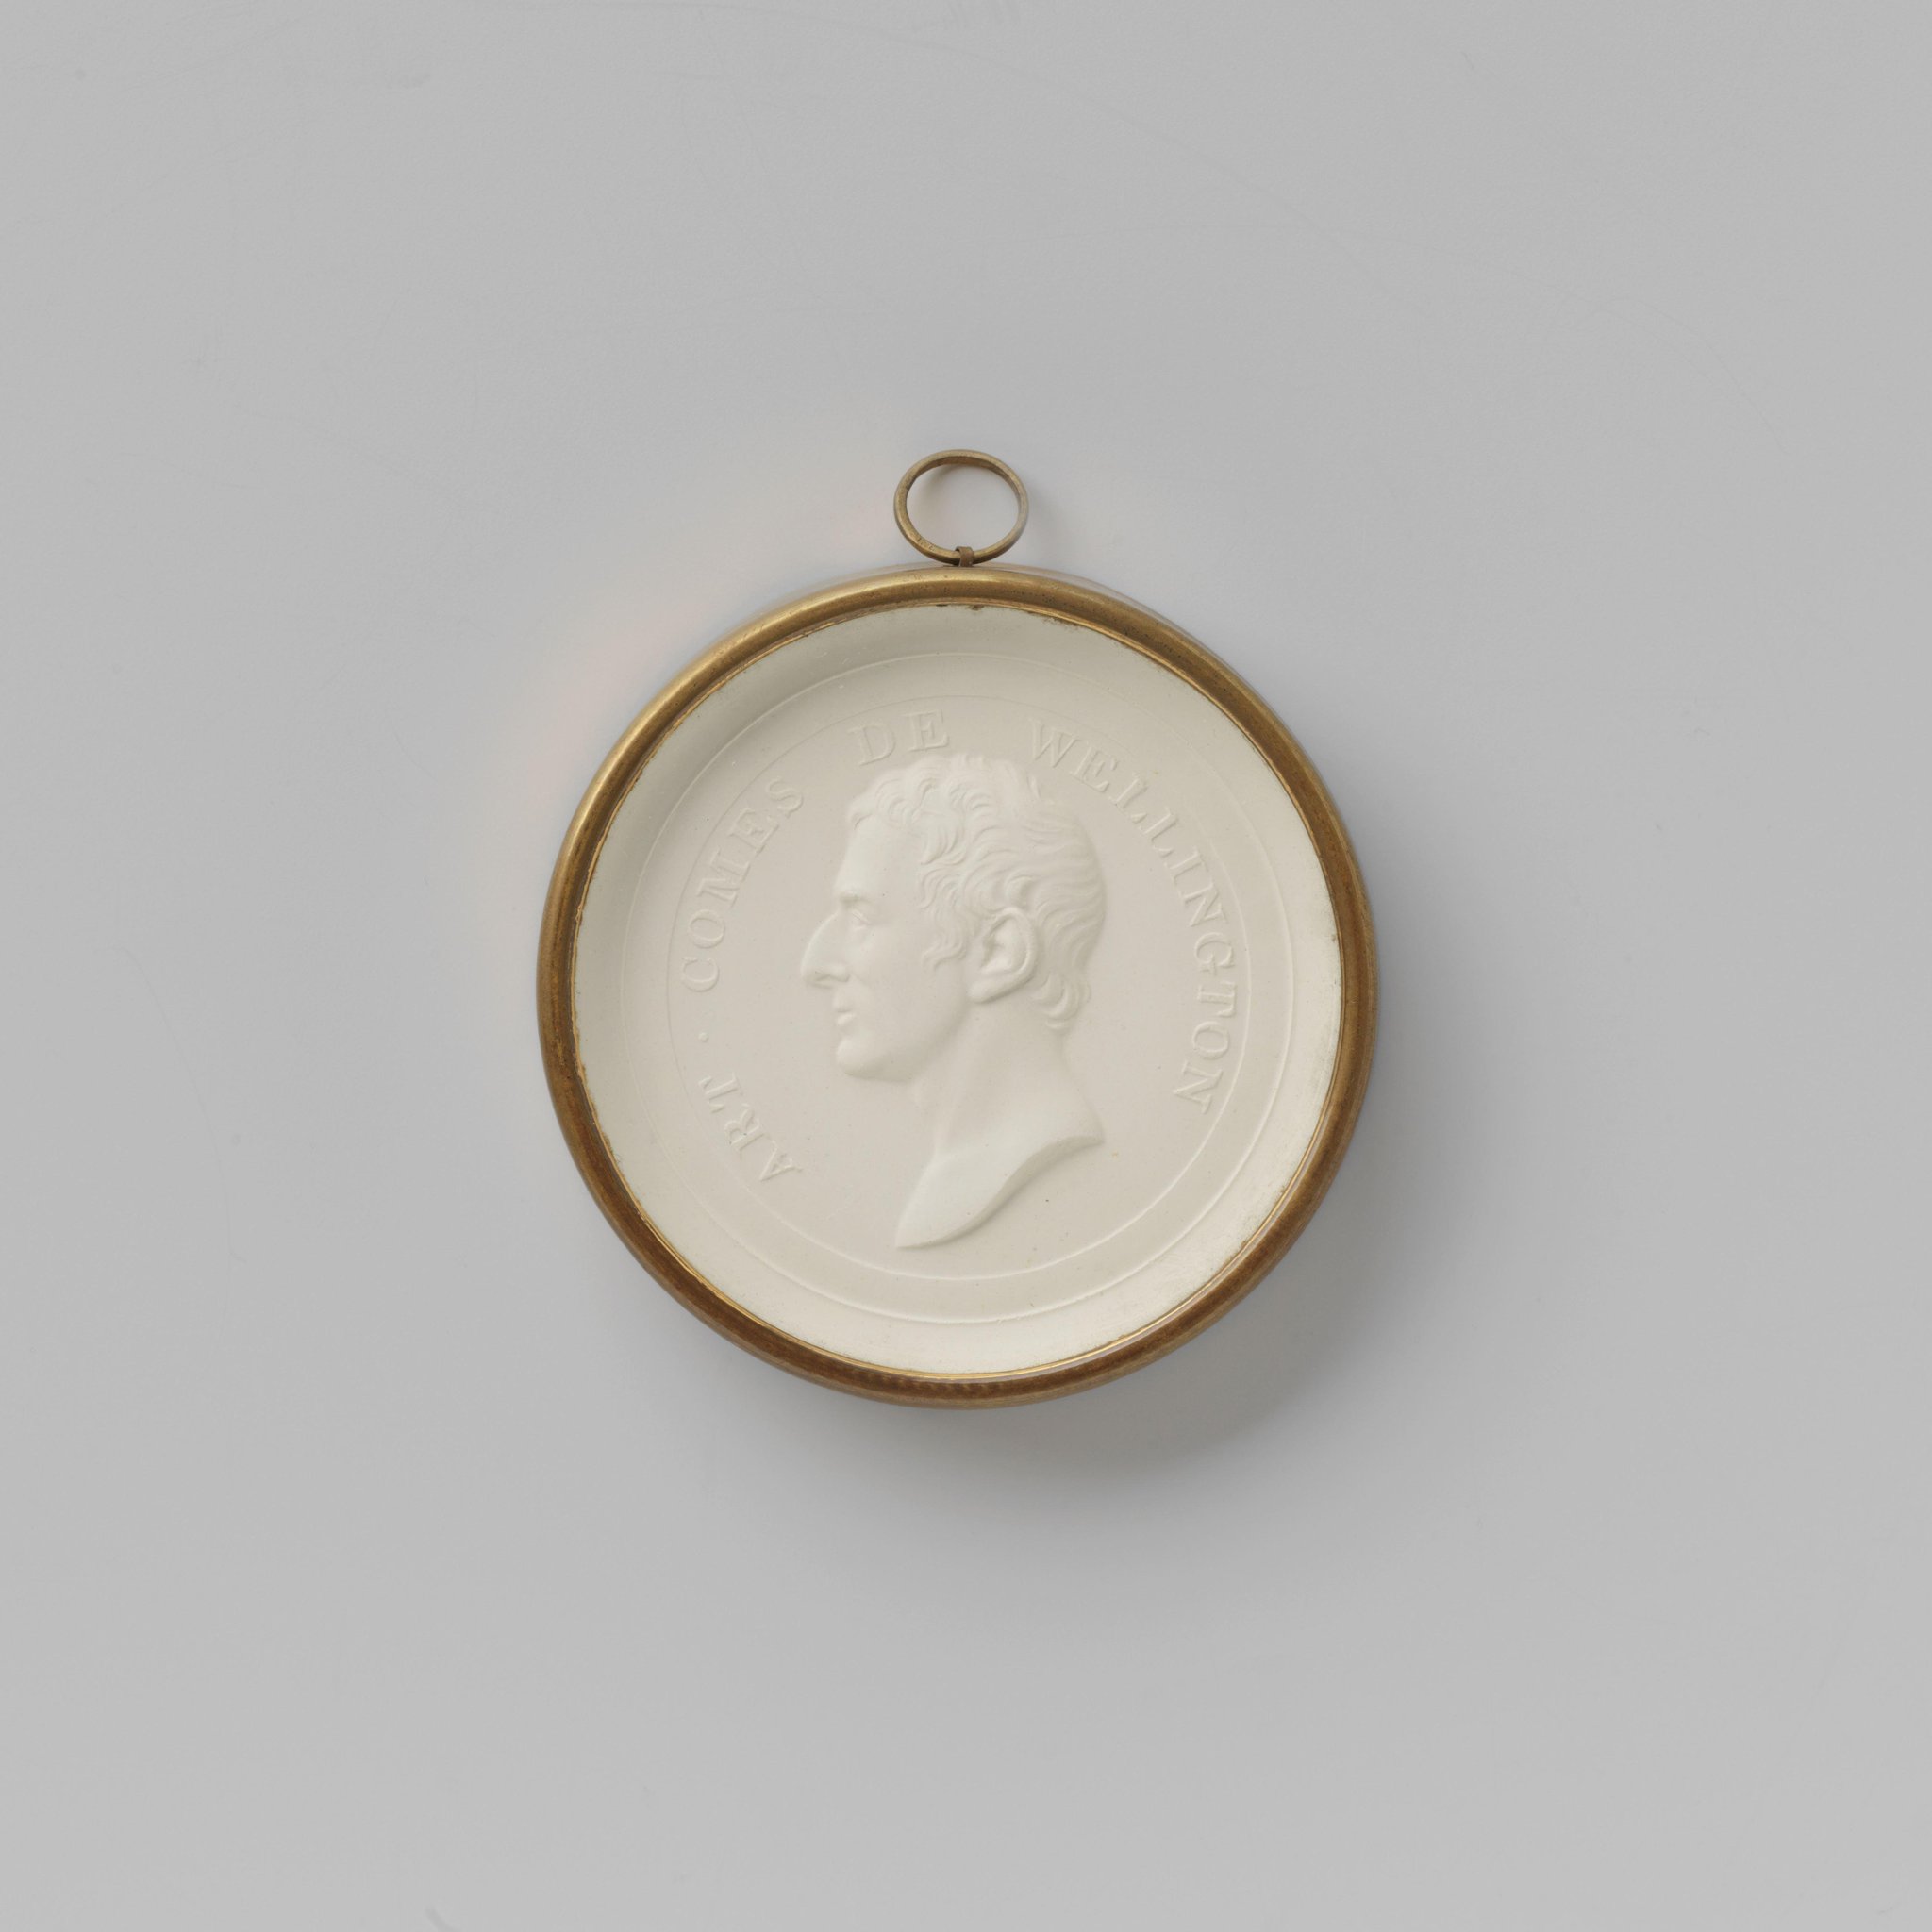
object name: locket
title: Arthur Wellesley, hertog van Wellington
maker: gottfried eichler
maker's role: draughtsman, painter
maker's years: 1677-1757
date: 1687-1757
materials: brass, glass, gypsum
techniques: casting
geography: berlin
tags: walmer castle, arthur wellesley of wellington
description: Eenzijdig medaillon in messing ring achter glas aan draagoog en draagring. Voorzijde: borststuk man naar links binnen omschrift. Keerzijde: etiket met opschrift.